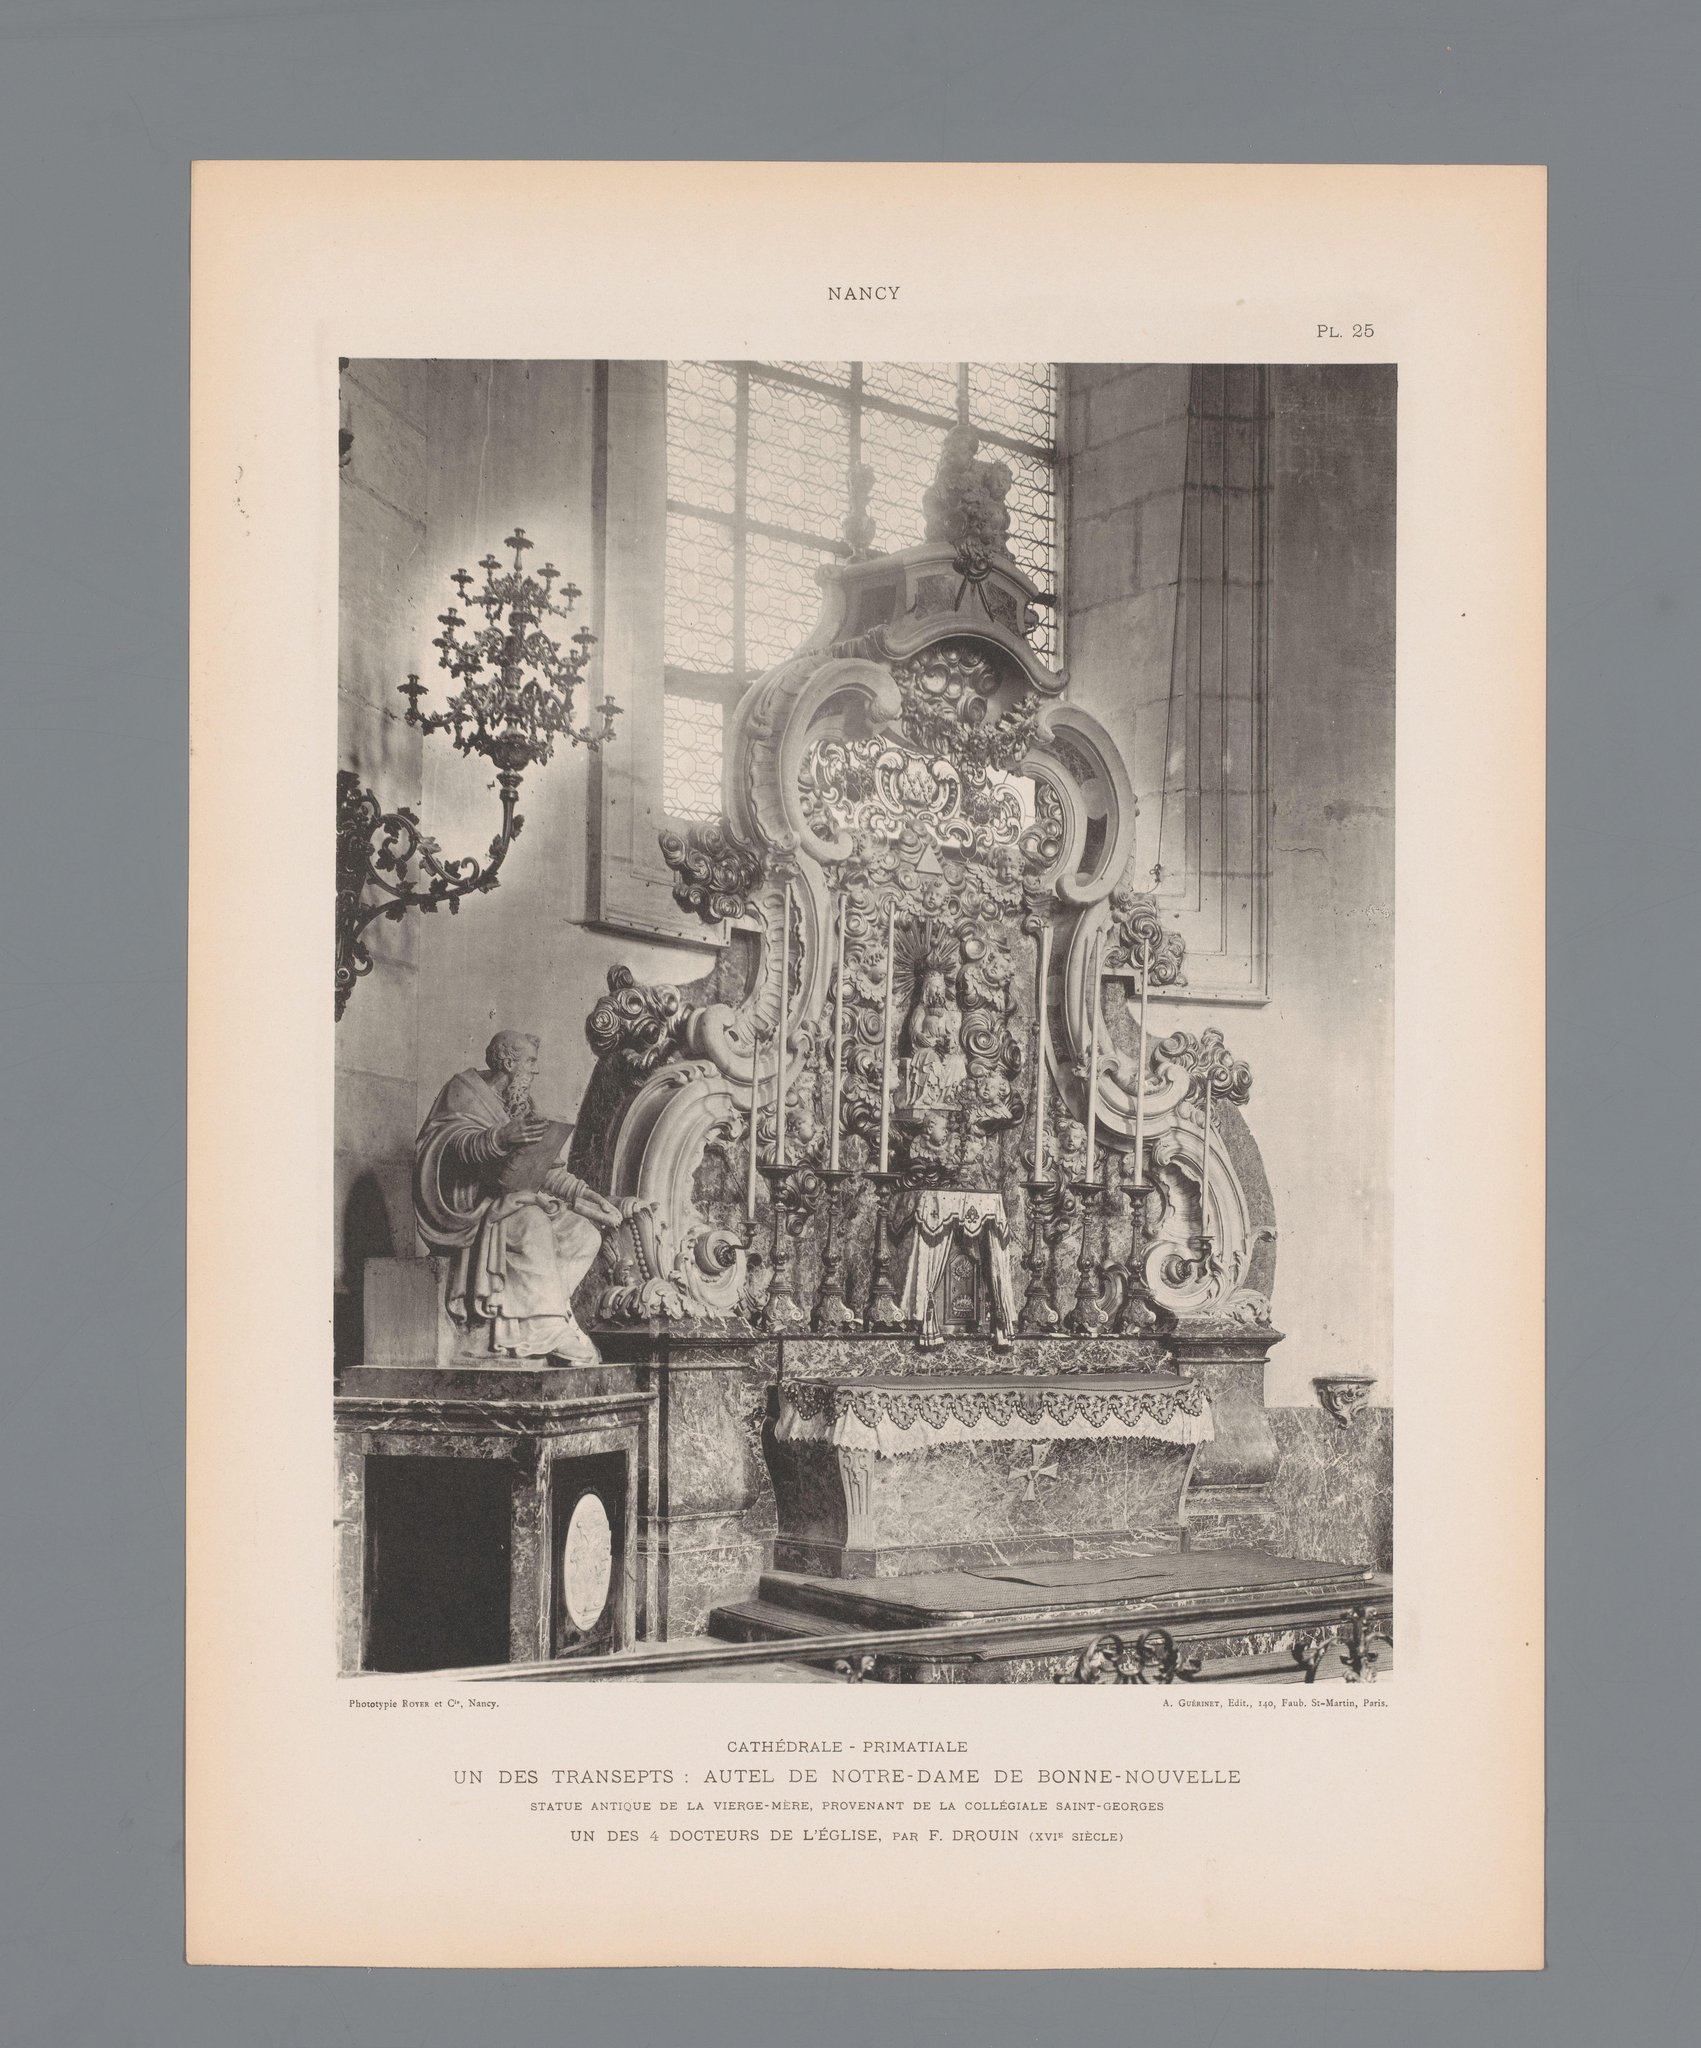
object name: photomechanical print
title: Altaar in de Notre-Dame de Saint-Sigisbert te Nancy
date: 1891-1896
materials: paper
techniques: photograph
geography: paris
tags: parts of church interior: transept, fixed altar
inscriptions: inscription: ‘Cathédrale - primatiale/ Un des transepts: autel de Notre-Dame de Bonne-Nouvelle (...)’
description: Deze prent maakt deel uit van een omslag met 103 prenten op 101 bladen en een titelblad.